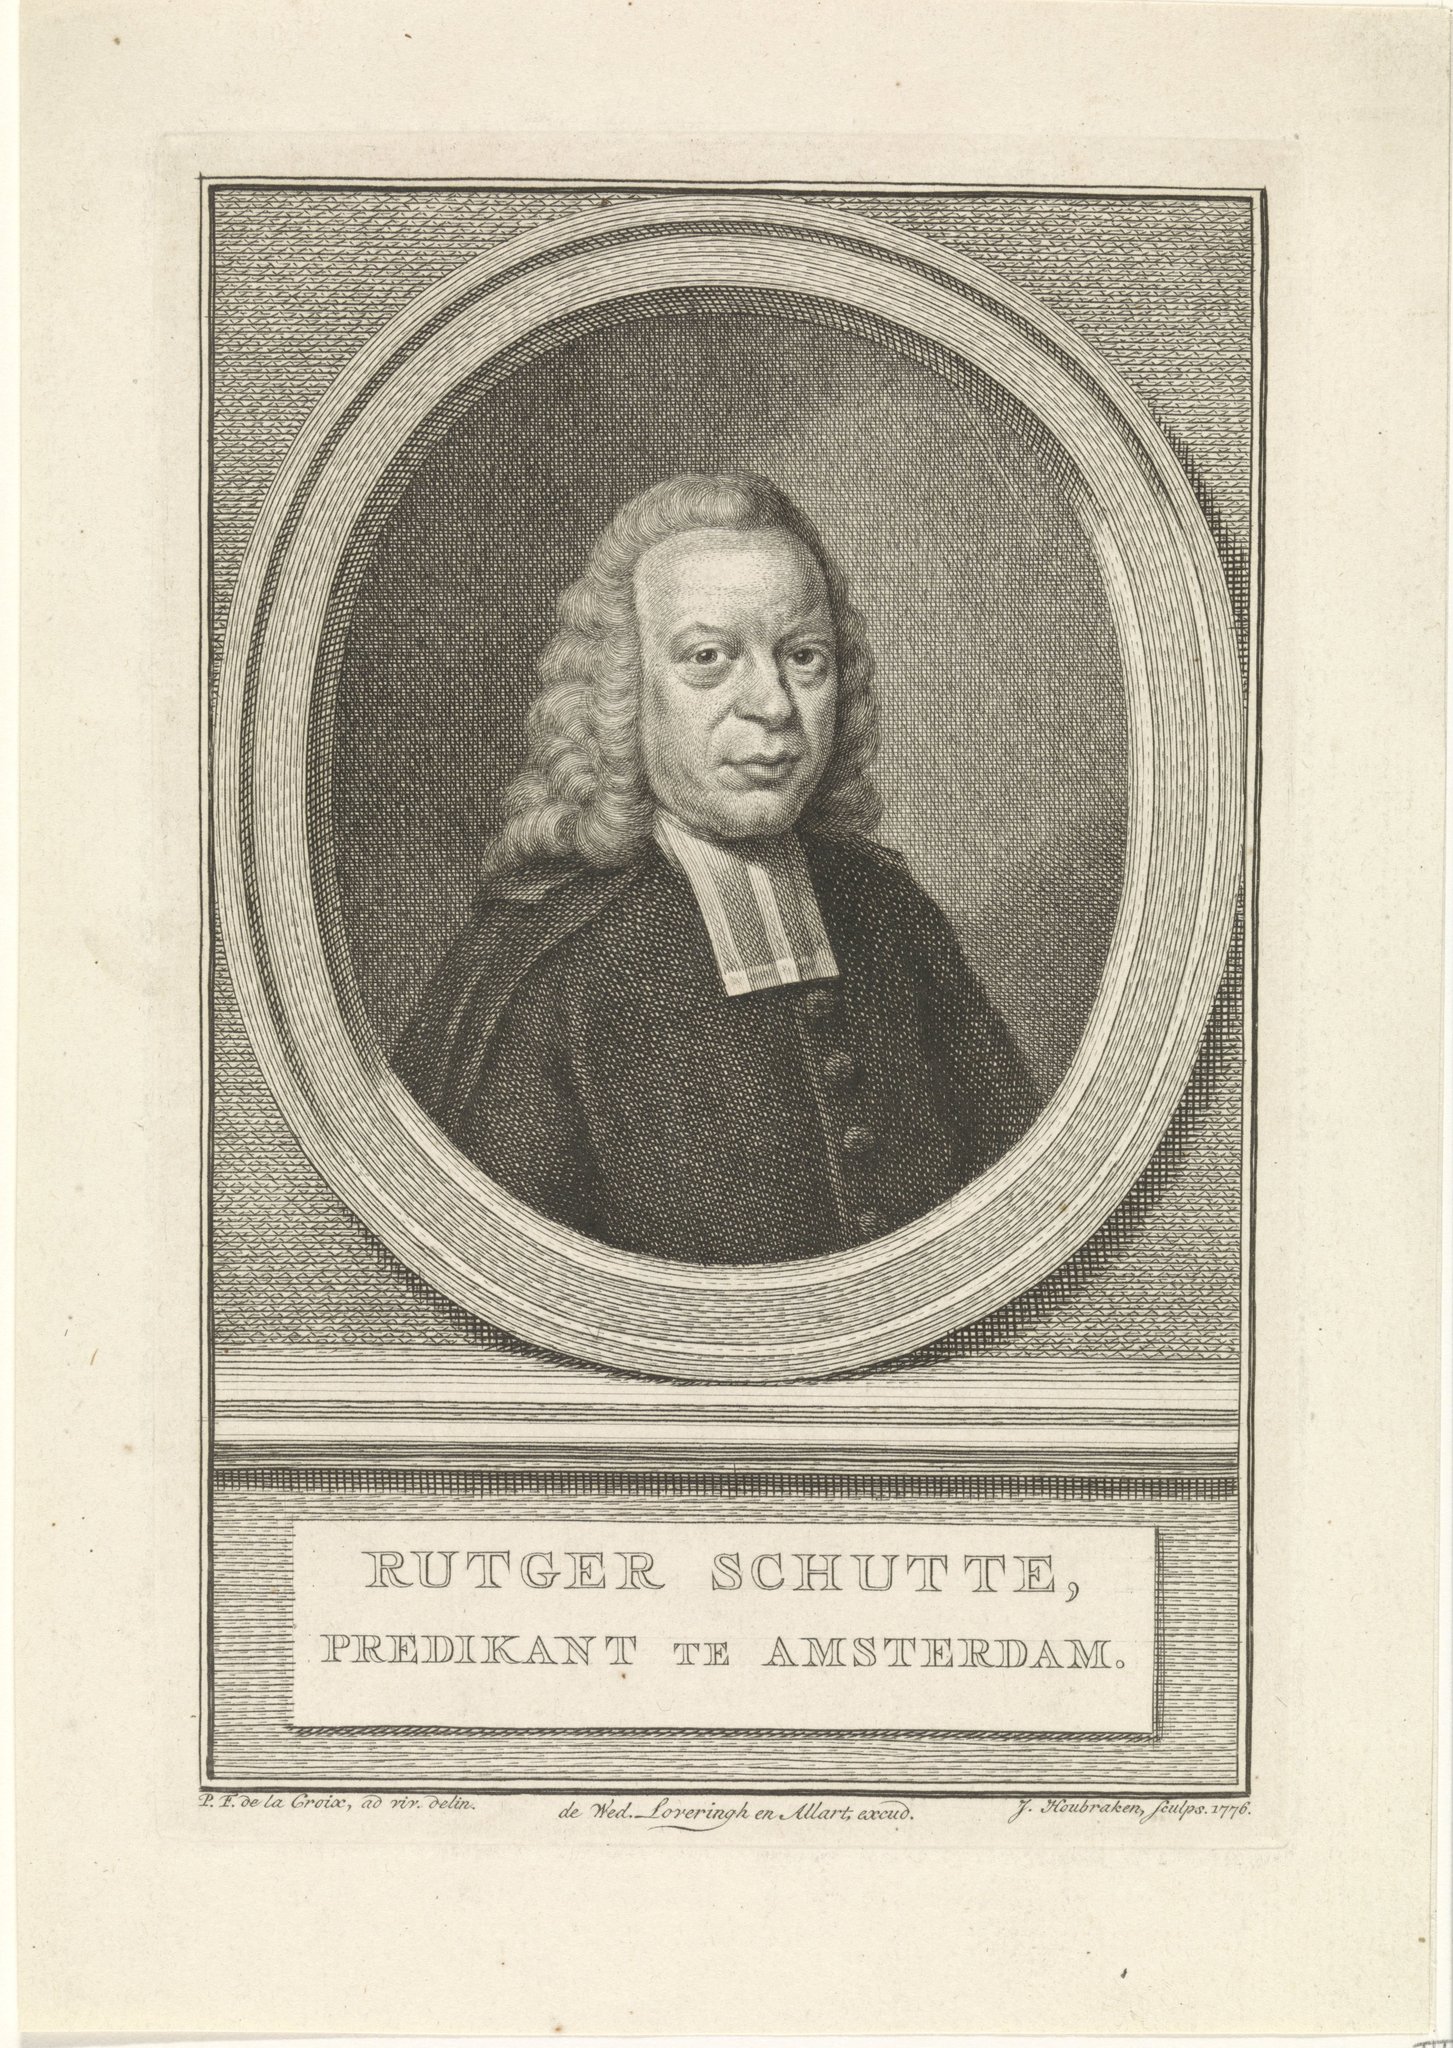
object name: print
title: Rutger Schutte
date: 1776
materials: paper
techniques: engraving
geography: amsterdam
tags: amsterdam, rutger schutte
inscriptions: collector's mark: Lugt 2228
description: Prent volgens Ver Huell ook gebruikt in: Josua van Iperen, Kerkelyke historie van het psalm-gezang der christenen (...) en inzonderheid van onze verbeterde Nederduitsche psalmberyminge. Amsterdam: wed. Loveringh en Allart, 1777. Deel 2: J. Allart, 1778. Eerste drie staten beschreven onder Ver Huell 378, vierde staat onder Ver Huell 379.